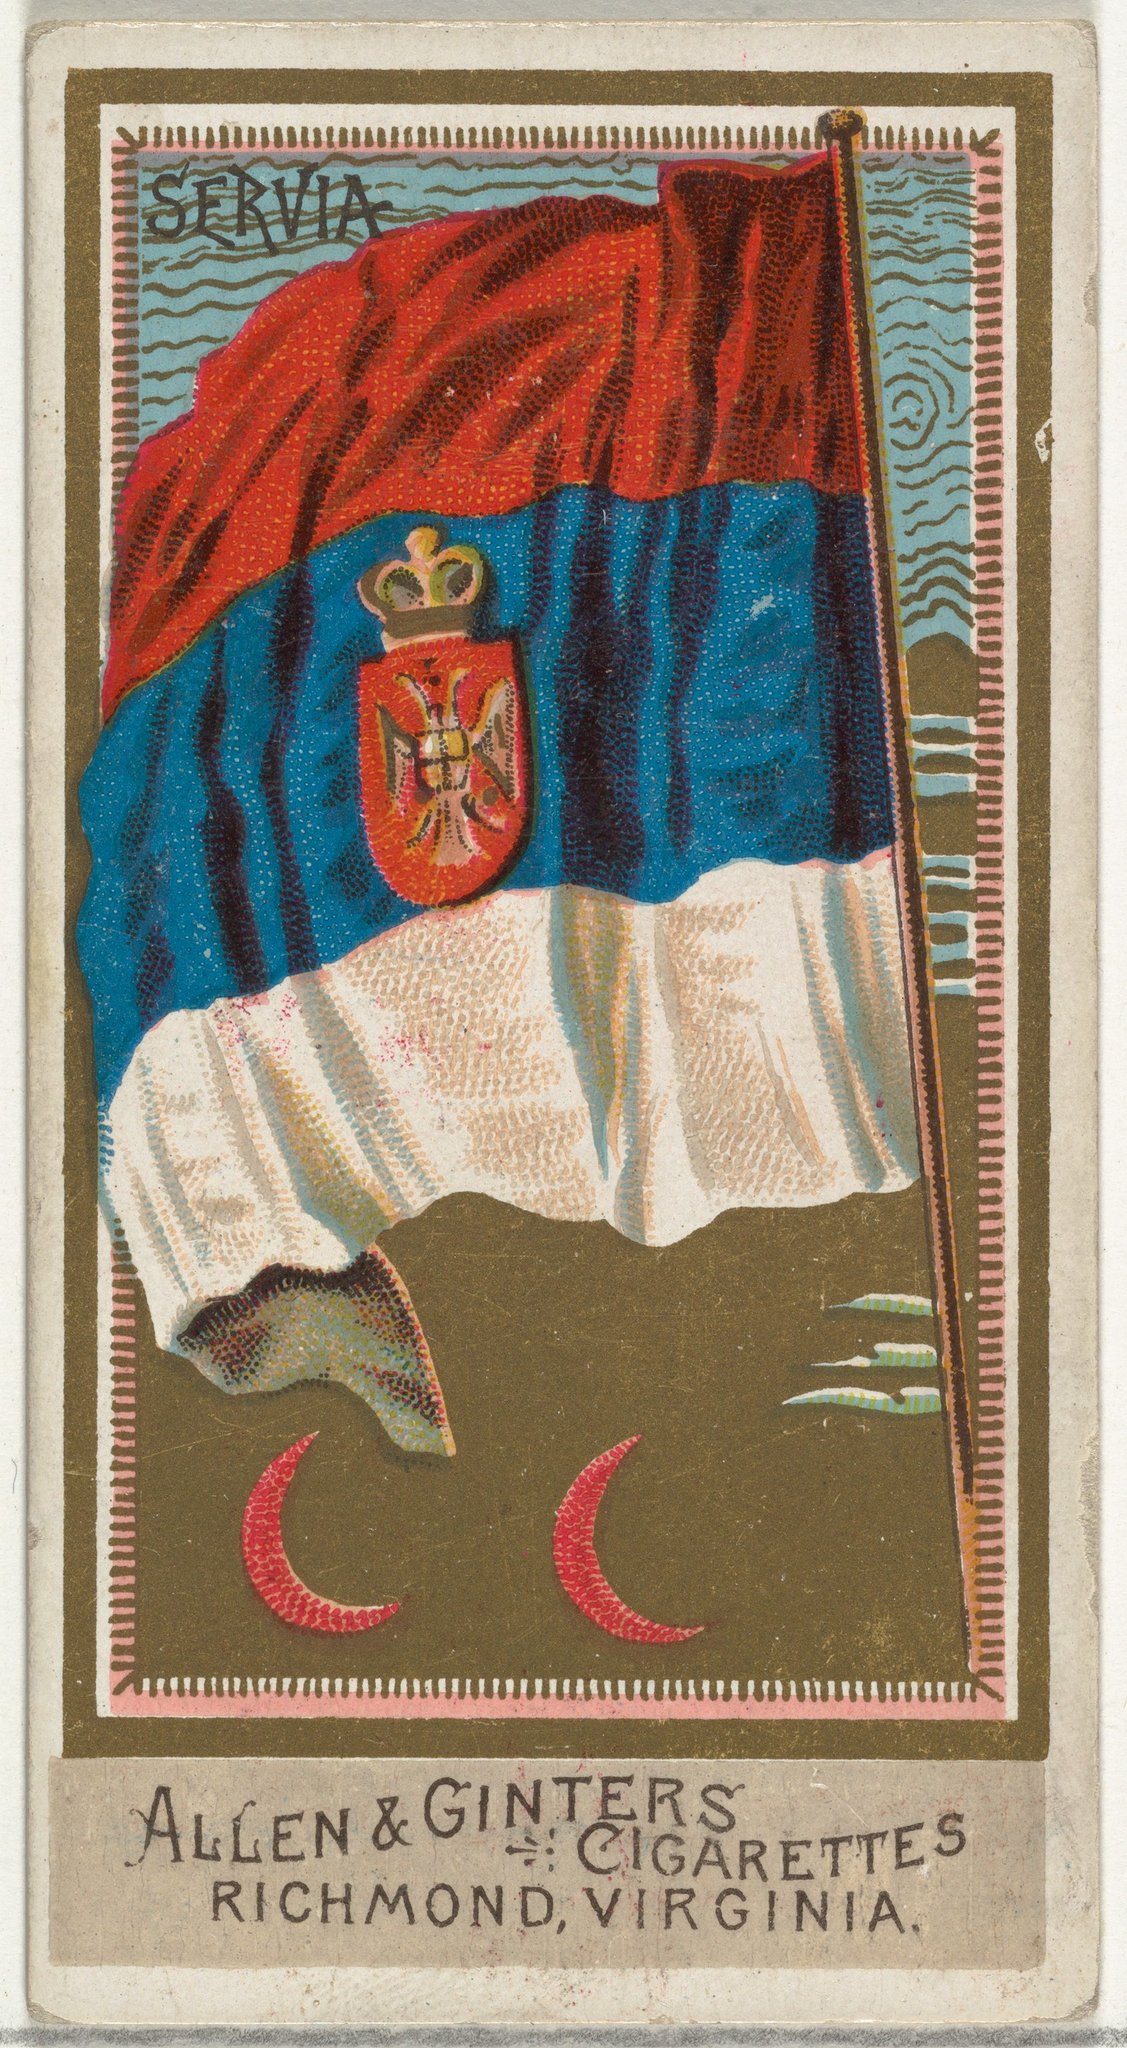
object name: print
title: Serbia, from Flags of All Nations, Series 2 (N10) for Allen & Ginter Cigarettes Brands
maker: allen & ginter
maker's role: publisher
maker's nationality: american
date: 1890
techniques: color lithograph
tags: flags